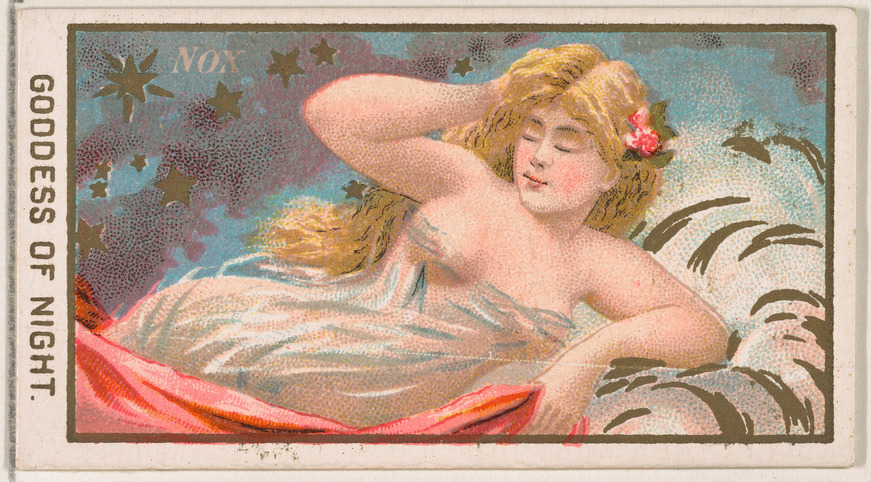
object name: print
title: Nox, Goddess of the Night, from the Goddesses of the Greeks and Romans series (N188) issued by Wm. S. Kimball & Co.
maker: william s. kimball & company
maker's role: publisher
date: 1889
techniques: color lithograph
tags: goddess